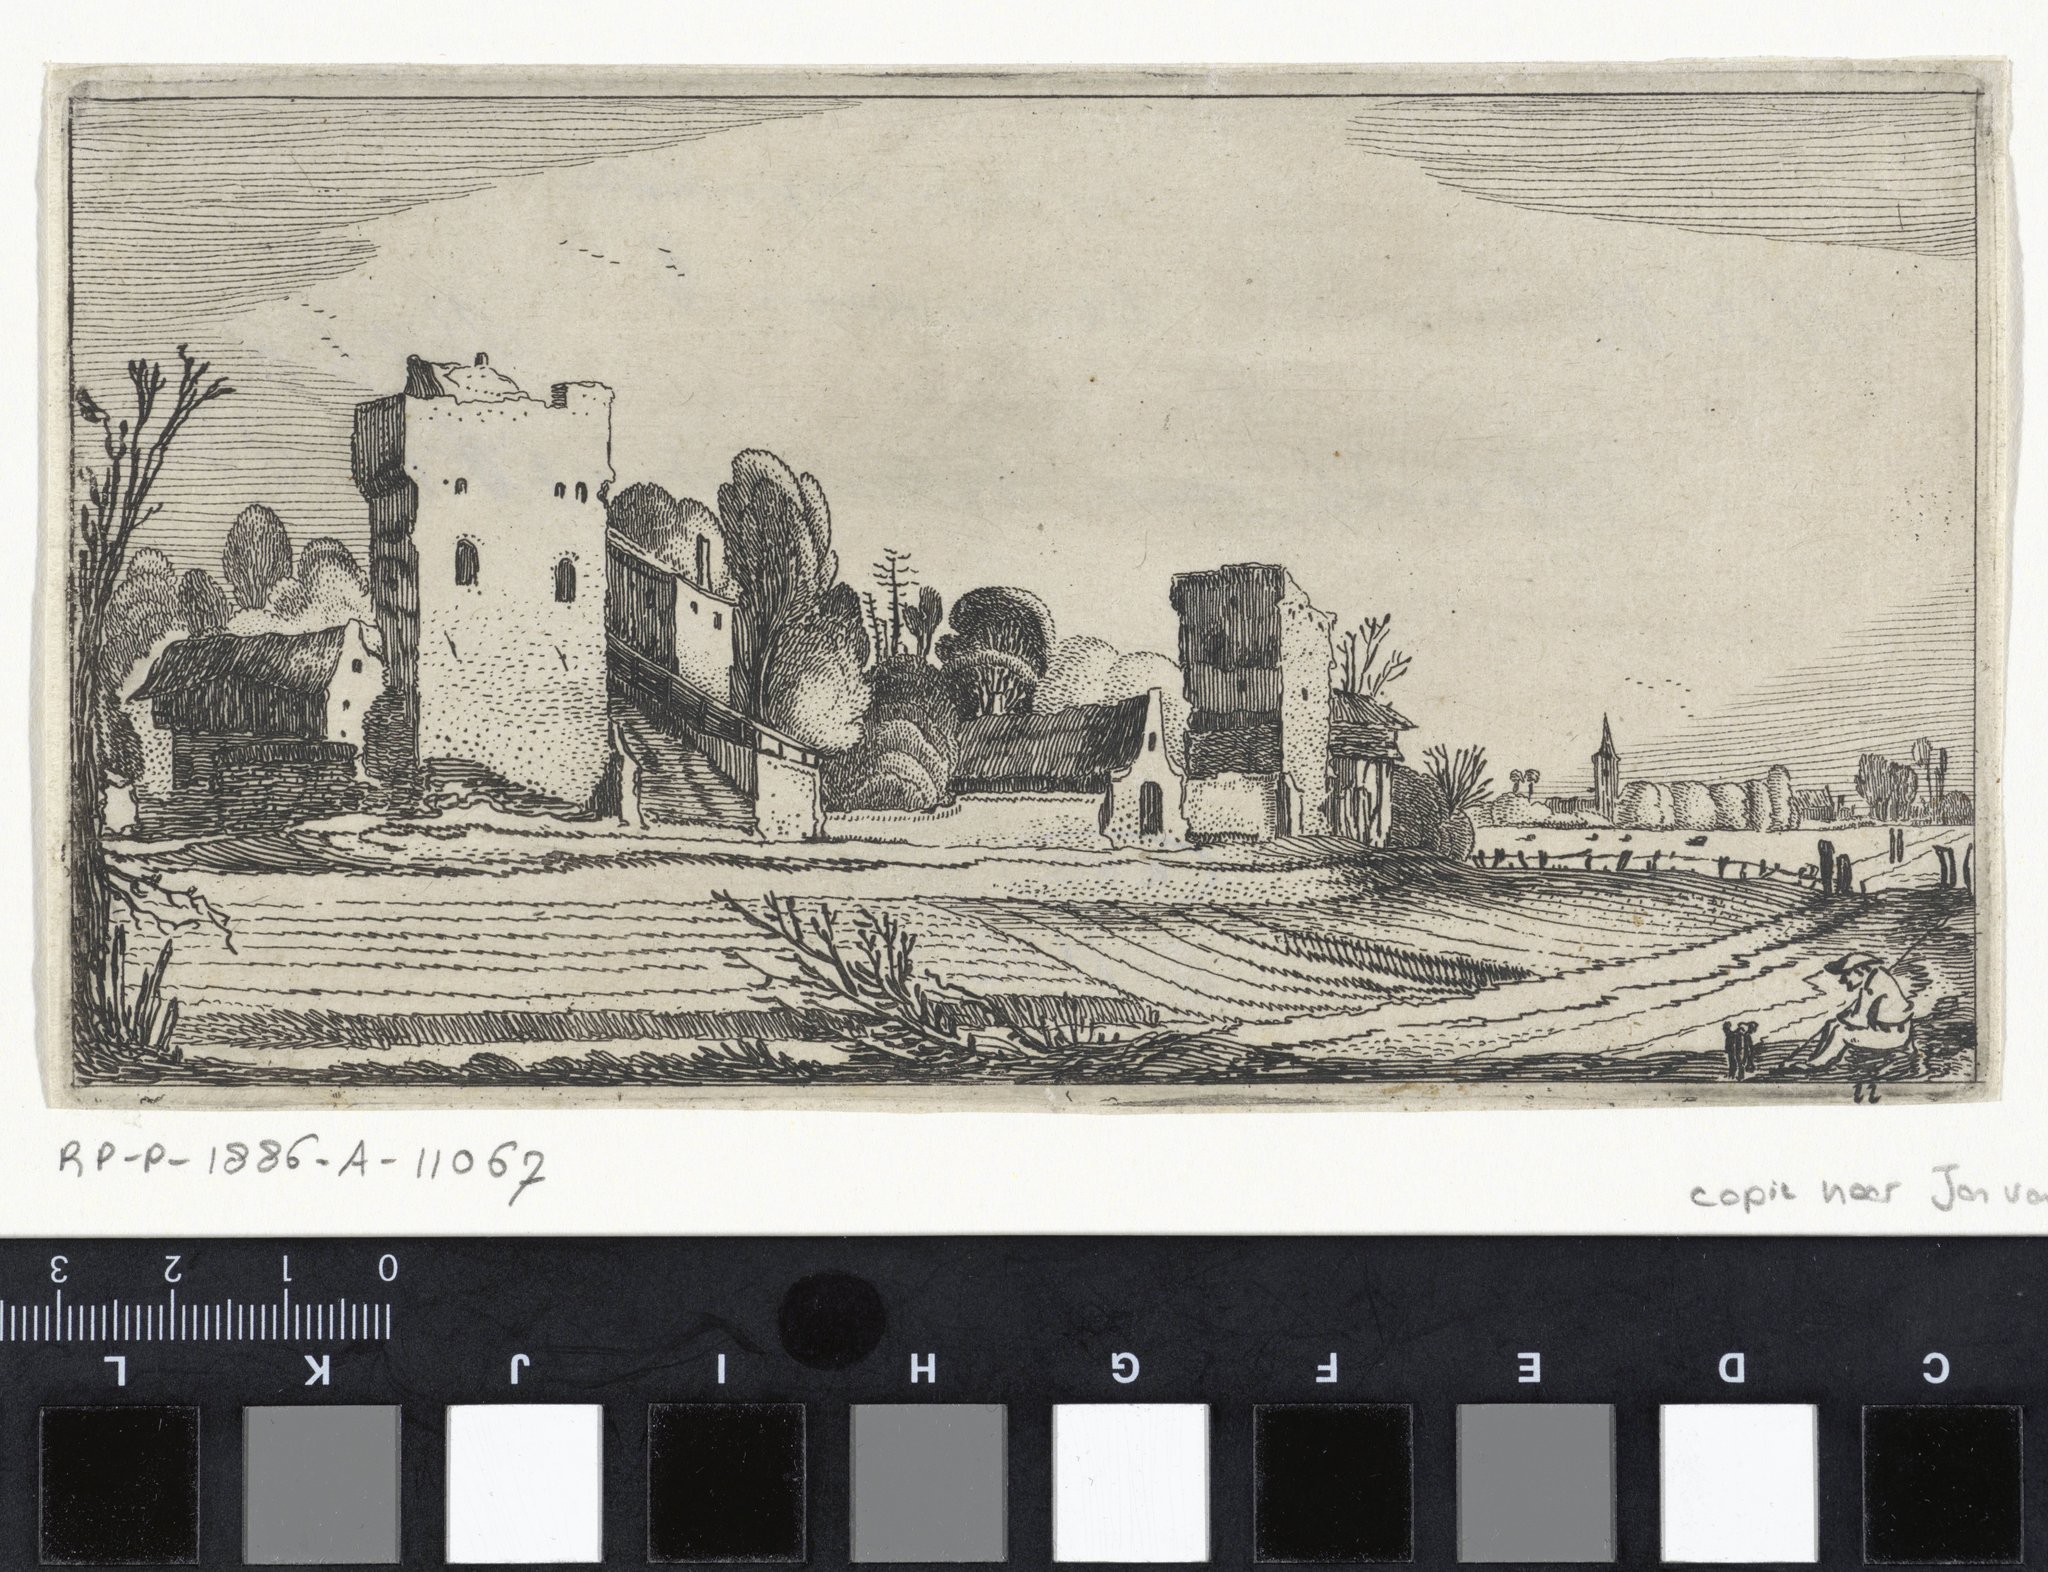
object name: print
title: Landschap met vervallen gebouwen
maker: claes jansz. visscher (ii)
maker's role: draughtsman, print maker, publisher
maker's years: 1586-1652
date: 1596-1630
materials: paper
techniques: etching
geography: amsterdam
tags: landscapes, ruin of church, monastery, etc., dog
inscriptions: collector's mark: Lugt 2228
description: Gezicht op een landschap met akkers, huizen en vervallen gebouwen. Rechts op de voorgrond zit een man op de grond. Zijn hond staat naast hem.